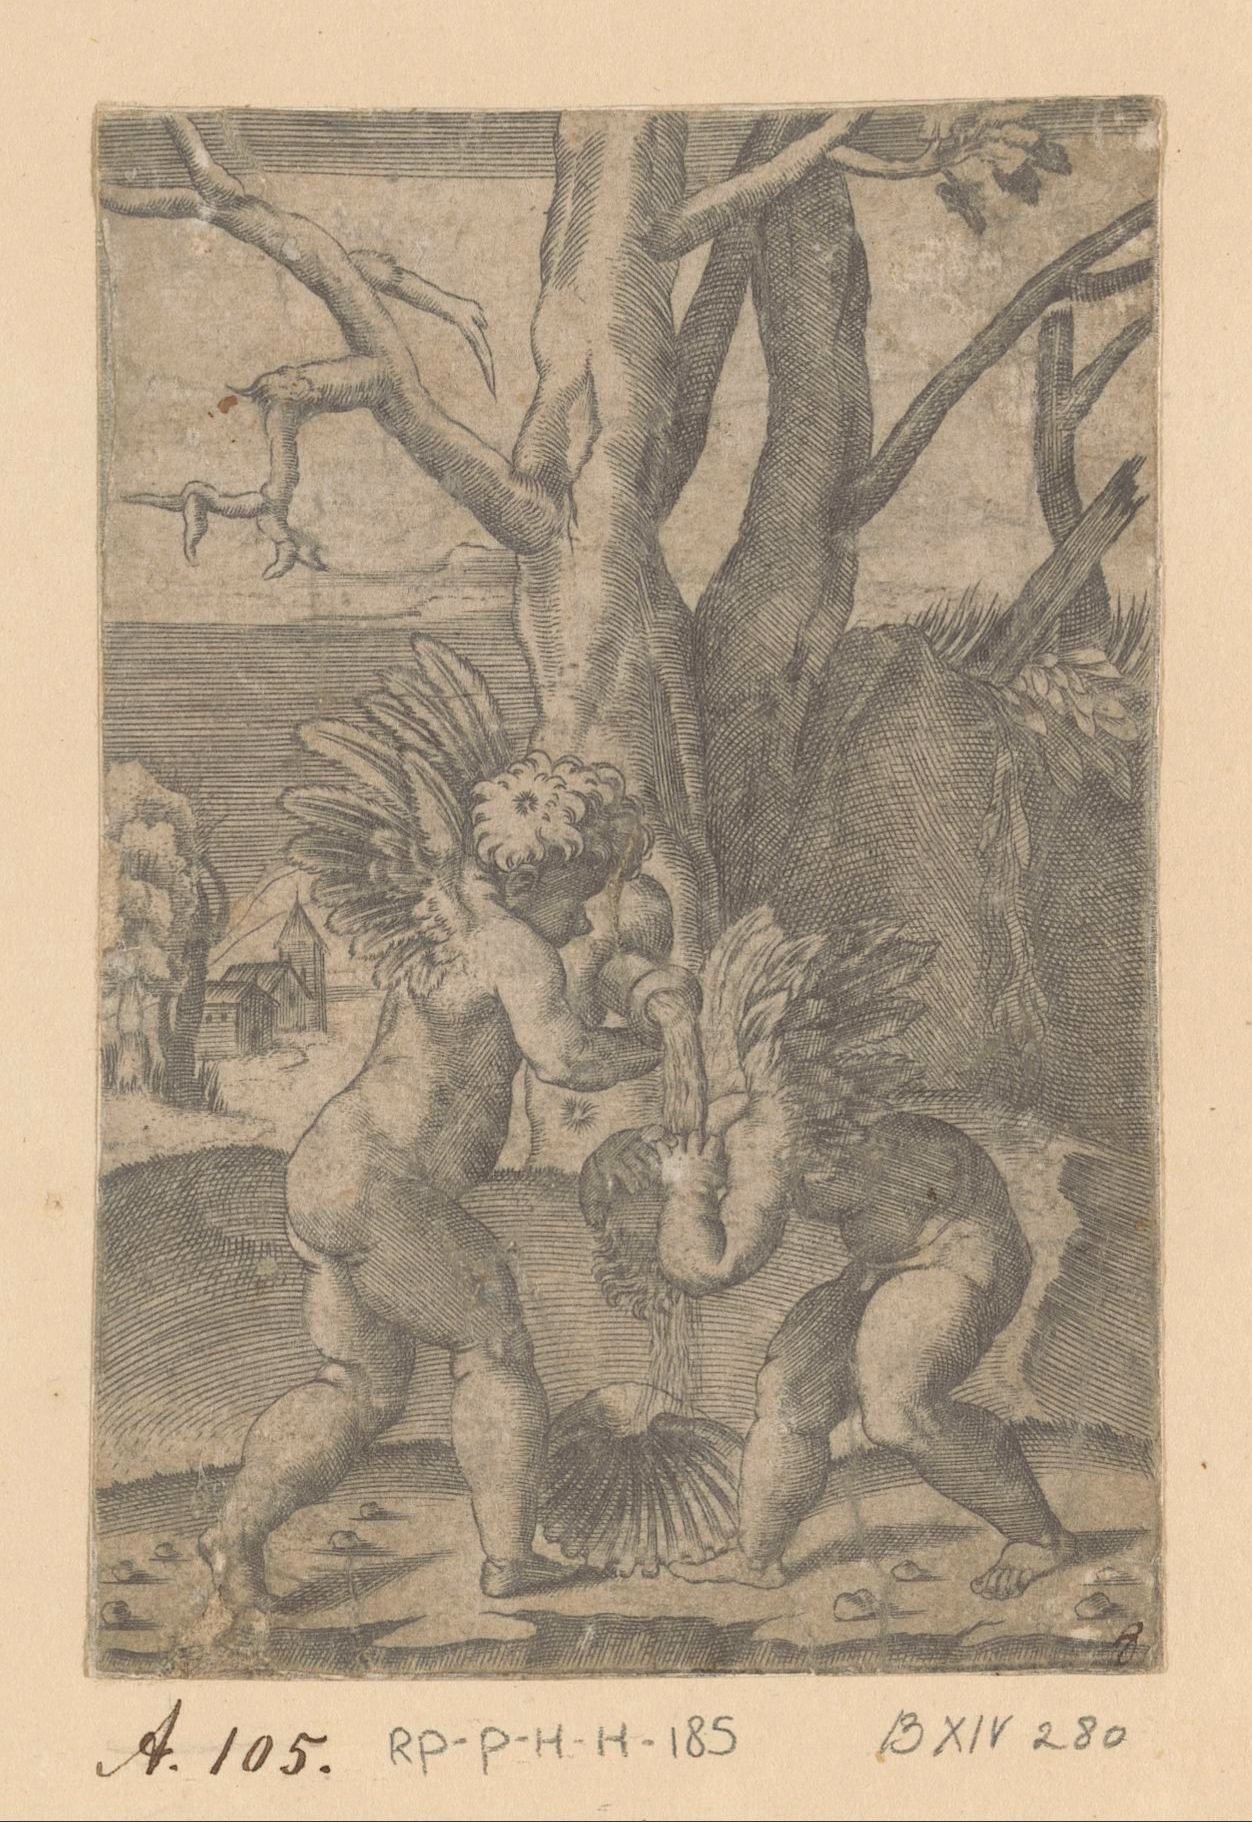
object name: print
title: Twee putti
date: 1500-1536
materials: paper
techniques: engraving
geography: italy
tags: pouring, cupids: 'amores', 'amoretti', 'putti'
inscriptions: number: ‘8’, collector's mark: Lugt 10, collector's mark: Lugt 11, collector's mark: ‘Hinloopen’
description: Twee putti staan op de voorgrond, een schelp ligt tussen hen in. De linker putto giet water uit een kruik over het hoofd van de rechter putto, die met zijn hoofd naar beneden gebogen staat. Achter hen bomen en een landschap met huizen.